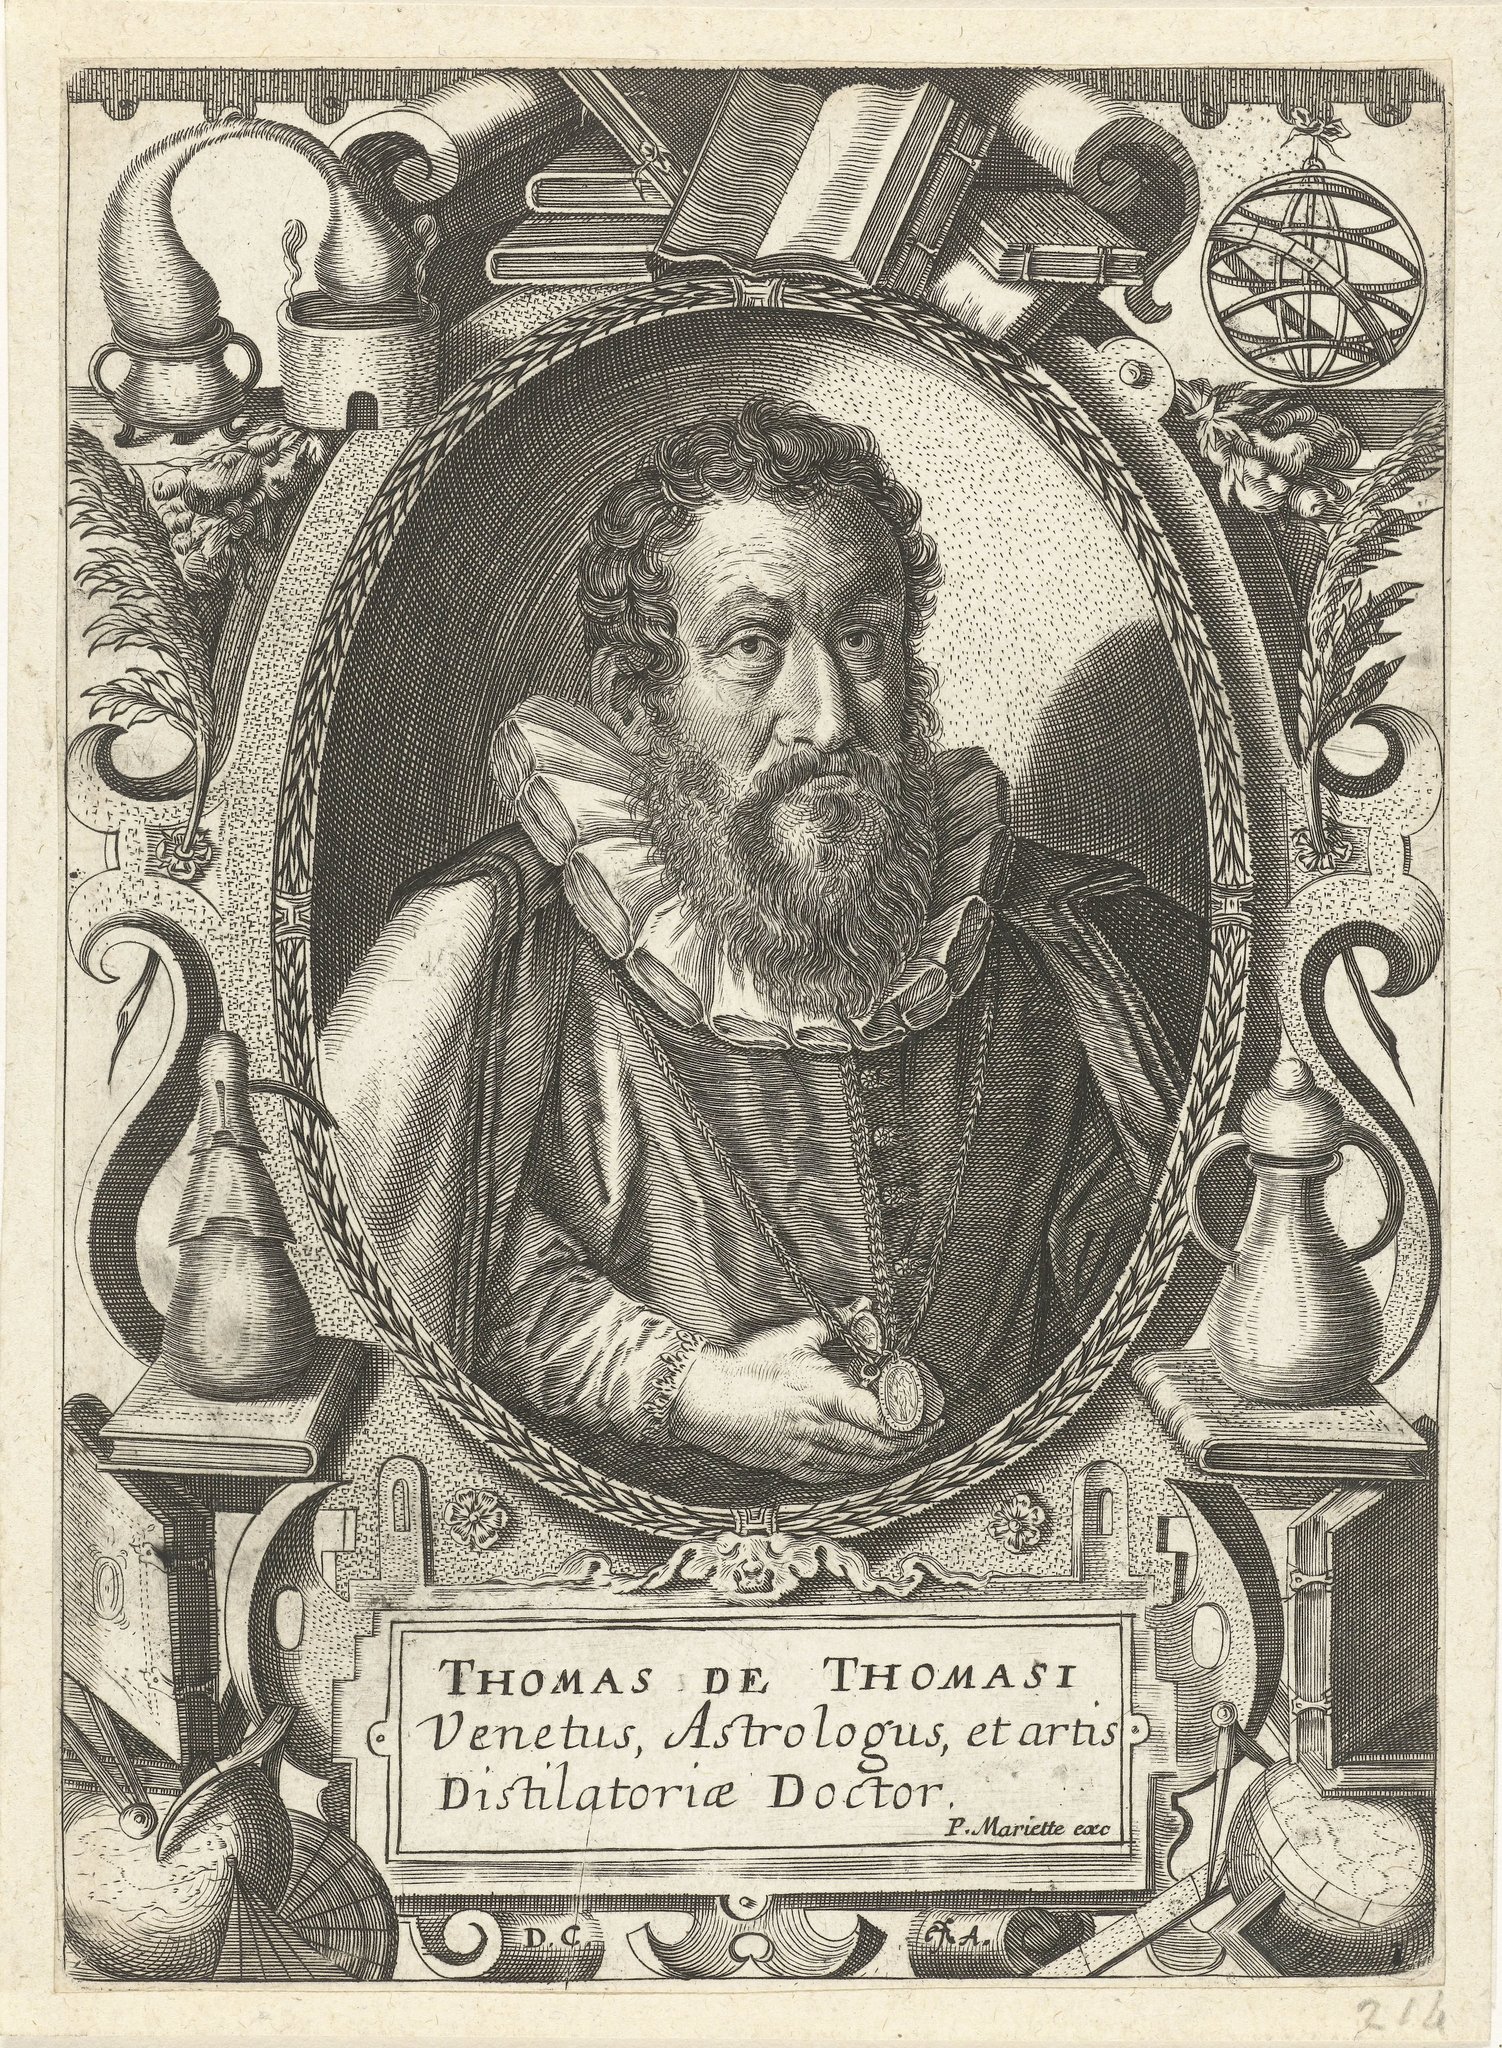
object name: print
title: Portret van de Venetiaanse astroloog Thomas de Thomasi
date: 1600-1650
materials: paper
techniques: engraving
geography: augsburg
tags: thomas de thomasi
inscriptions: collector's mark: Lugt 2228